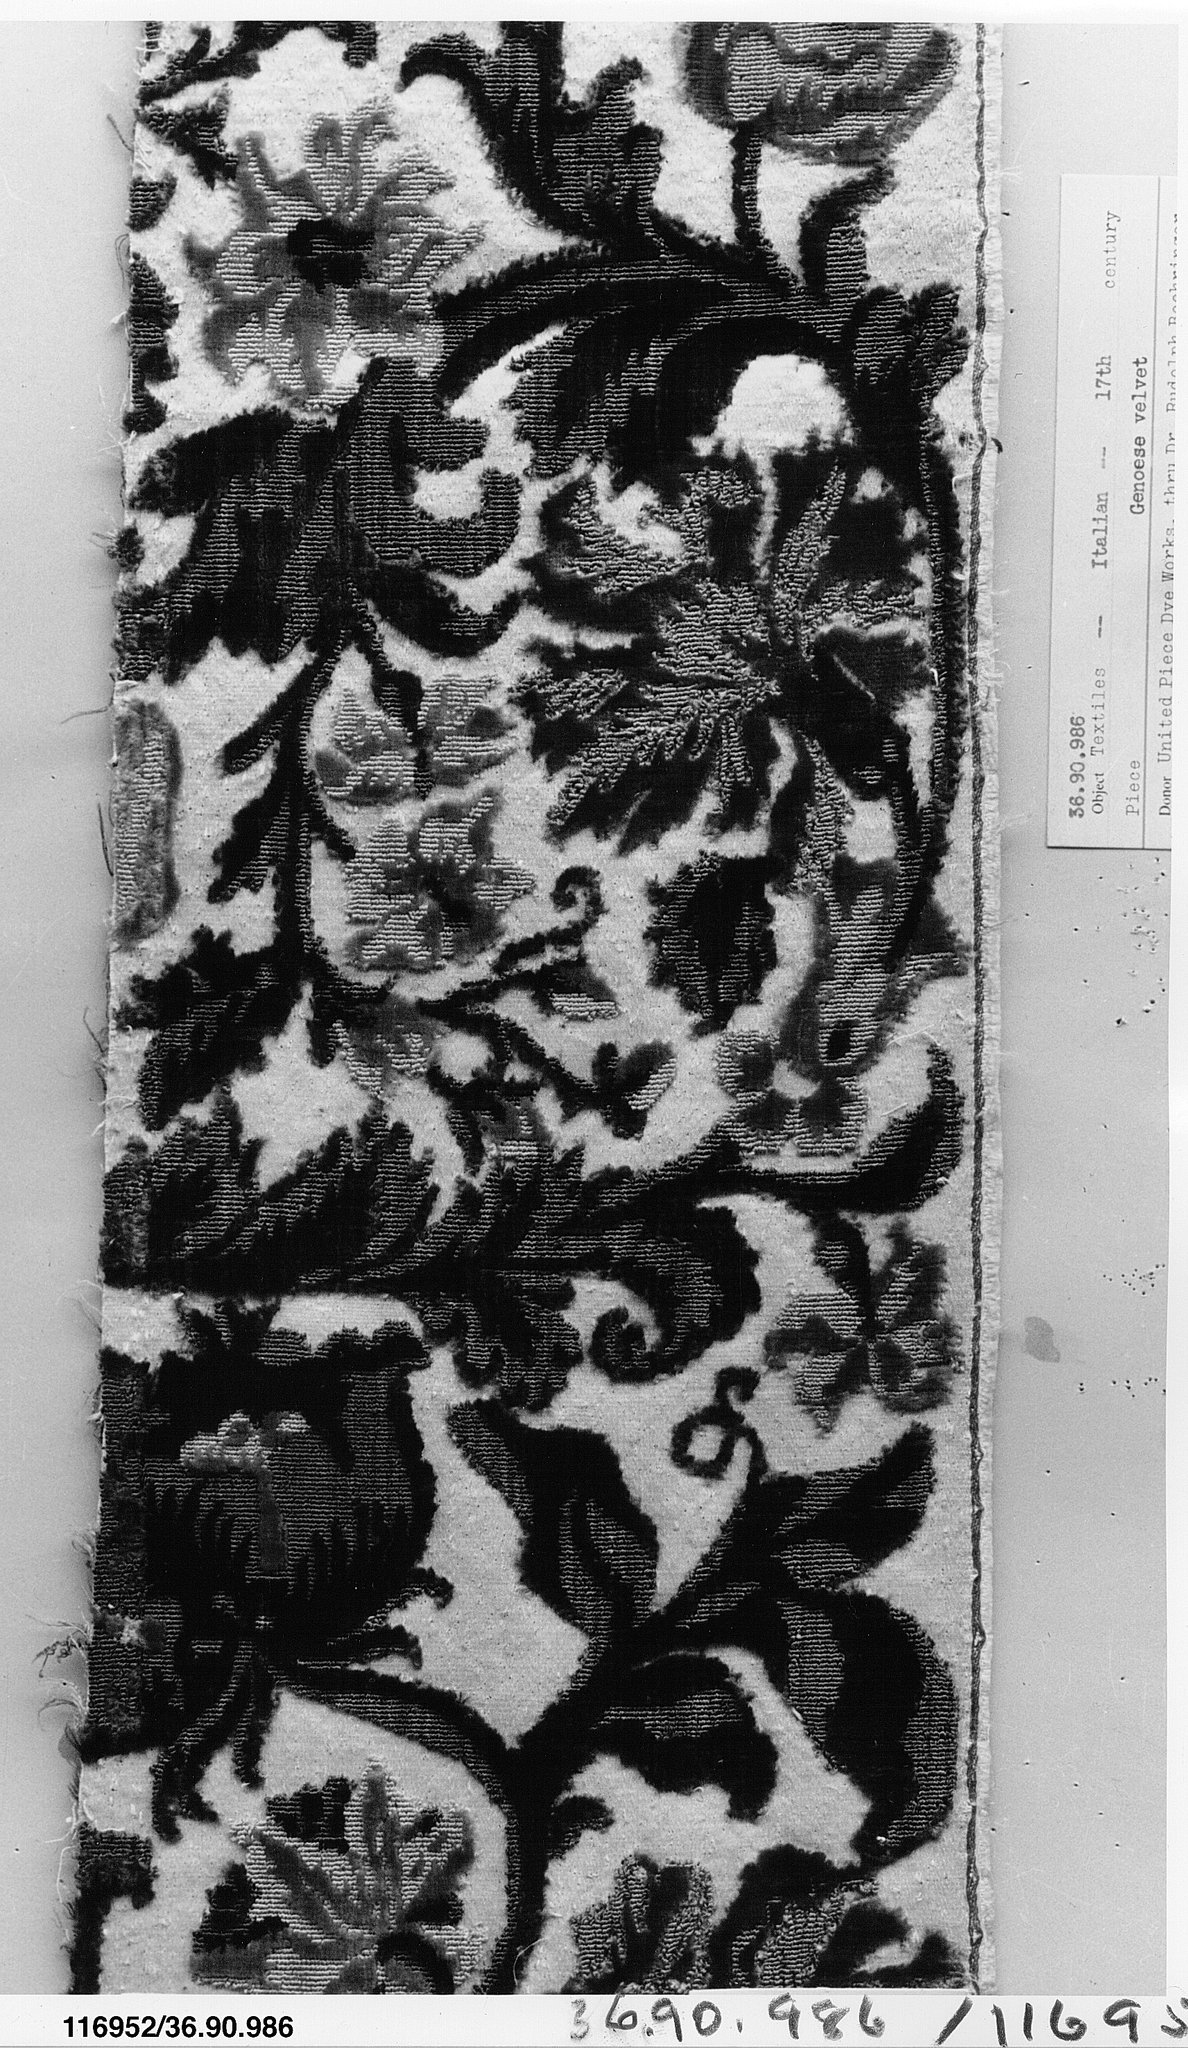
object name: piece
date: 1740-1750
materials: silk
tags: flowers,leaves